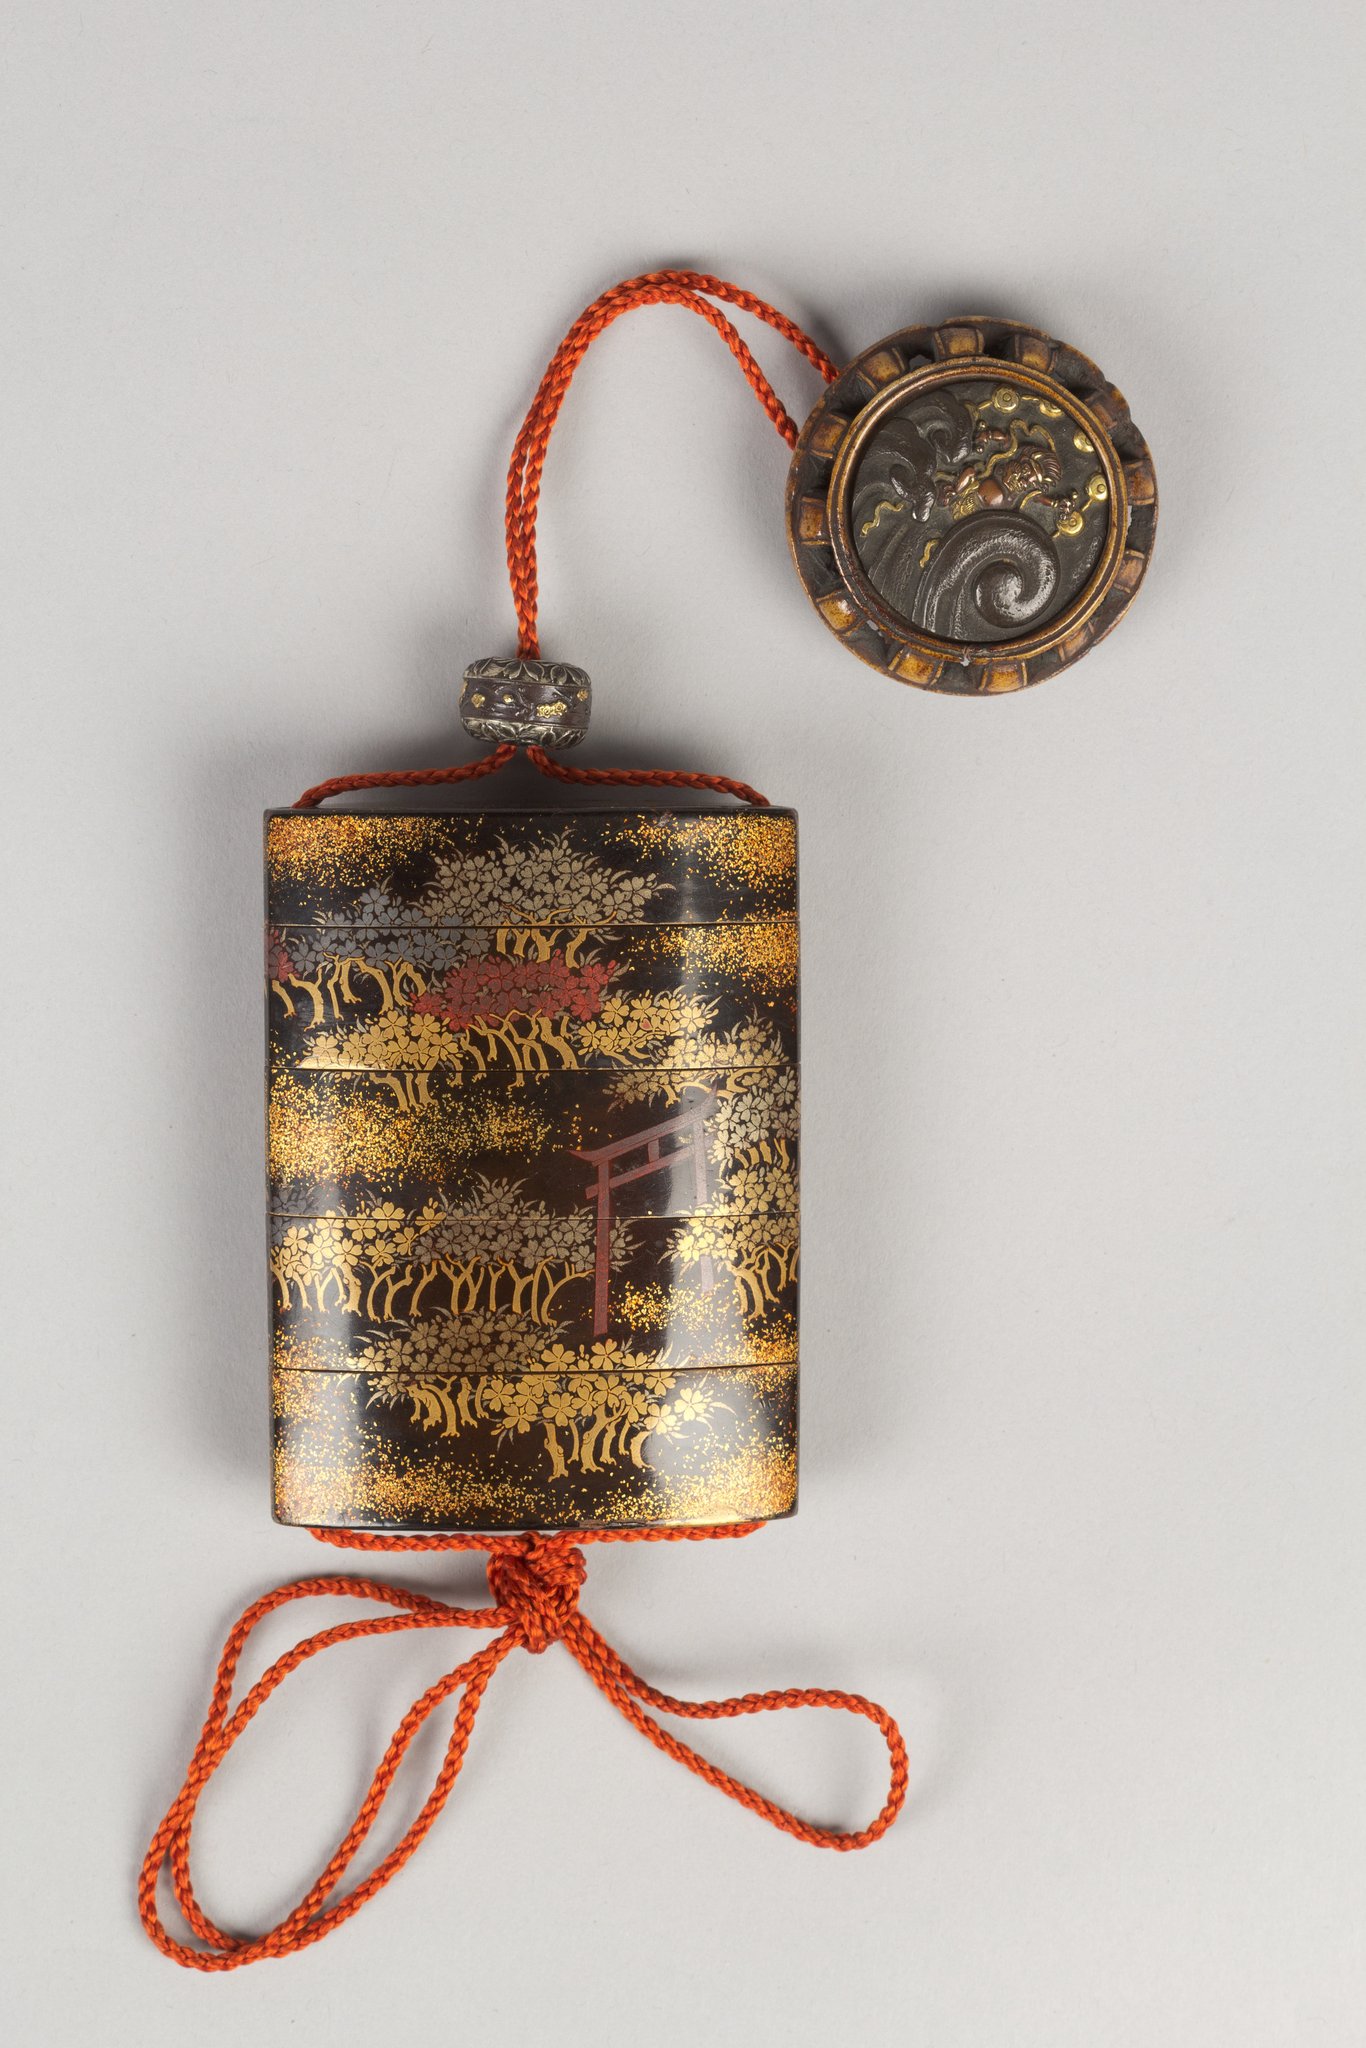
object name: inrō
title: Case (Inrō) with Design of Cherry Trees with a Shintō Shrine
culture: japanese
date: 1801-1900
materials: gold, lacquer, silver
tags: trees,shintō